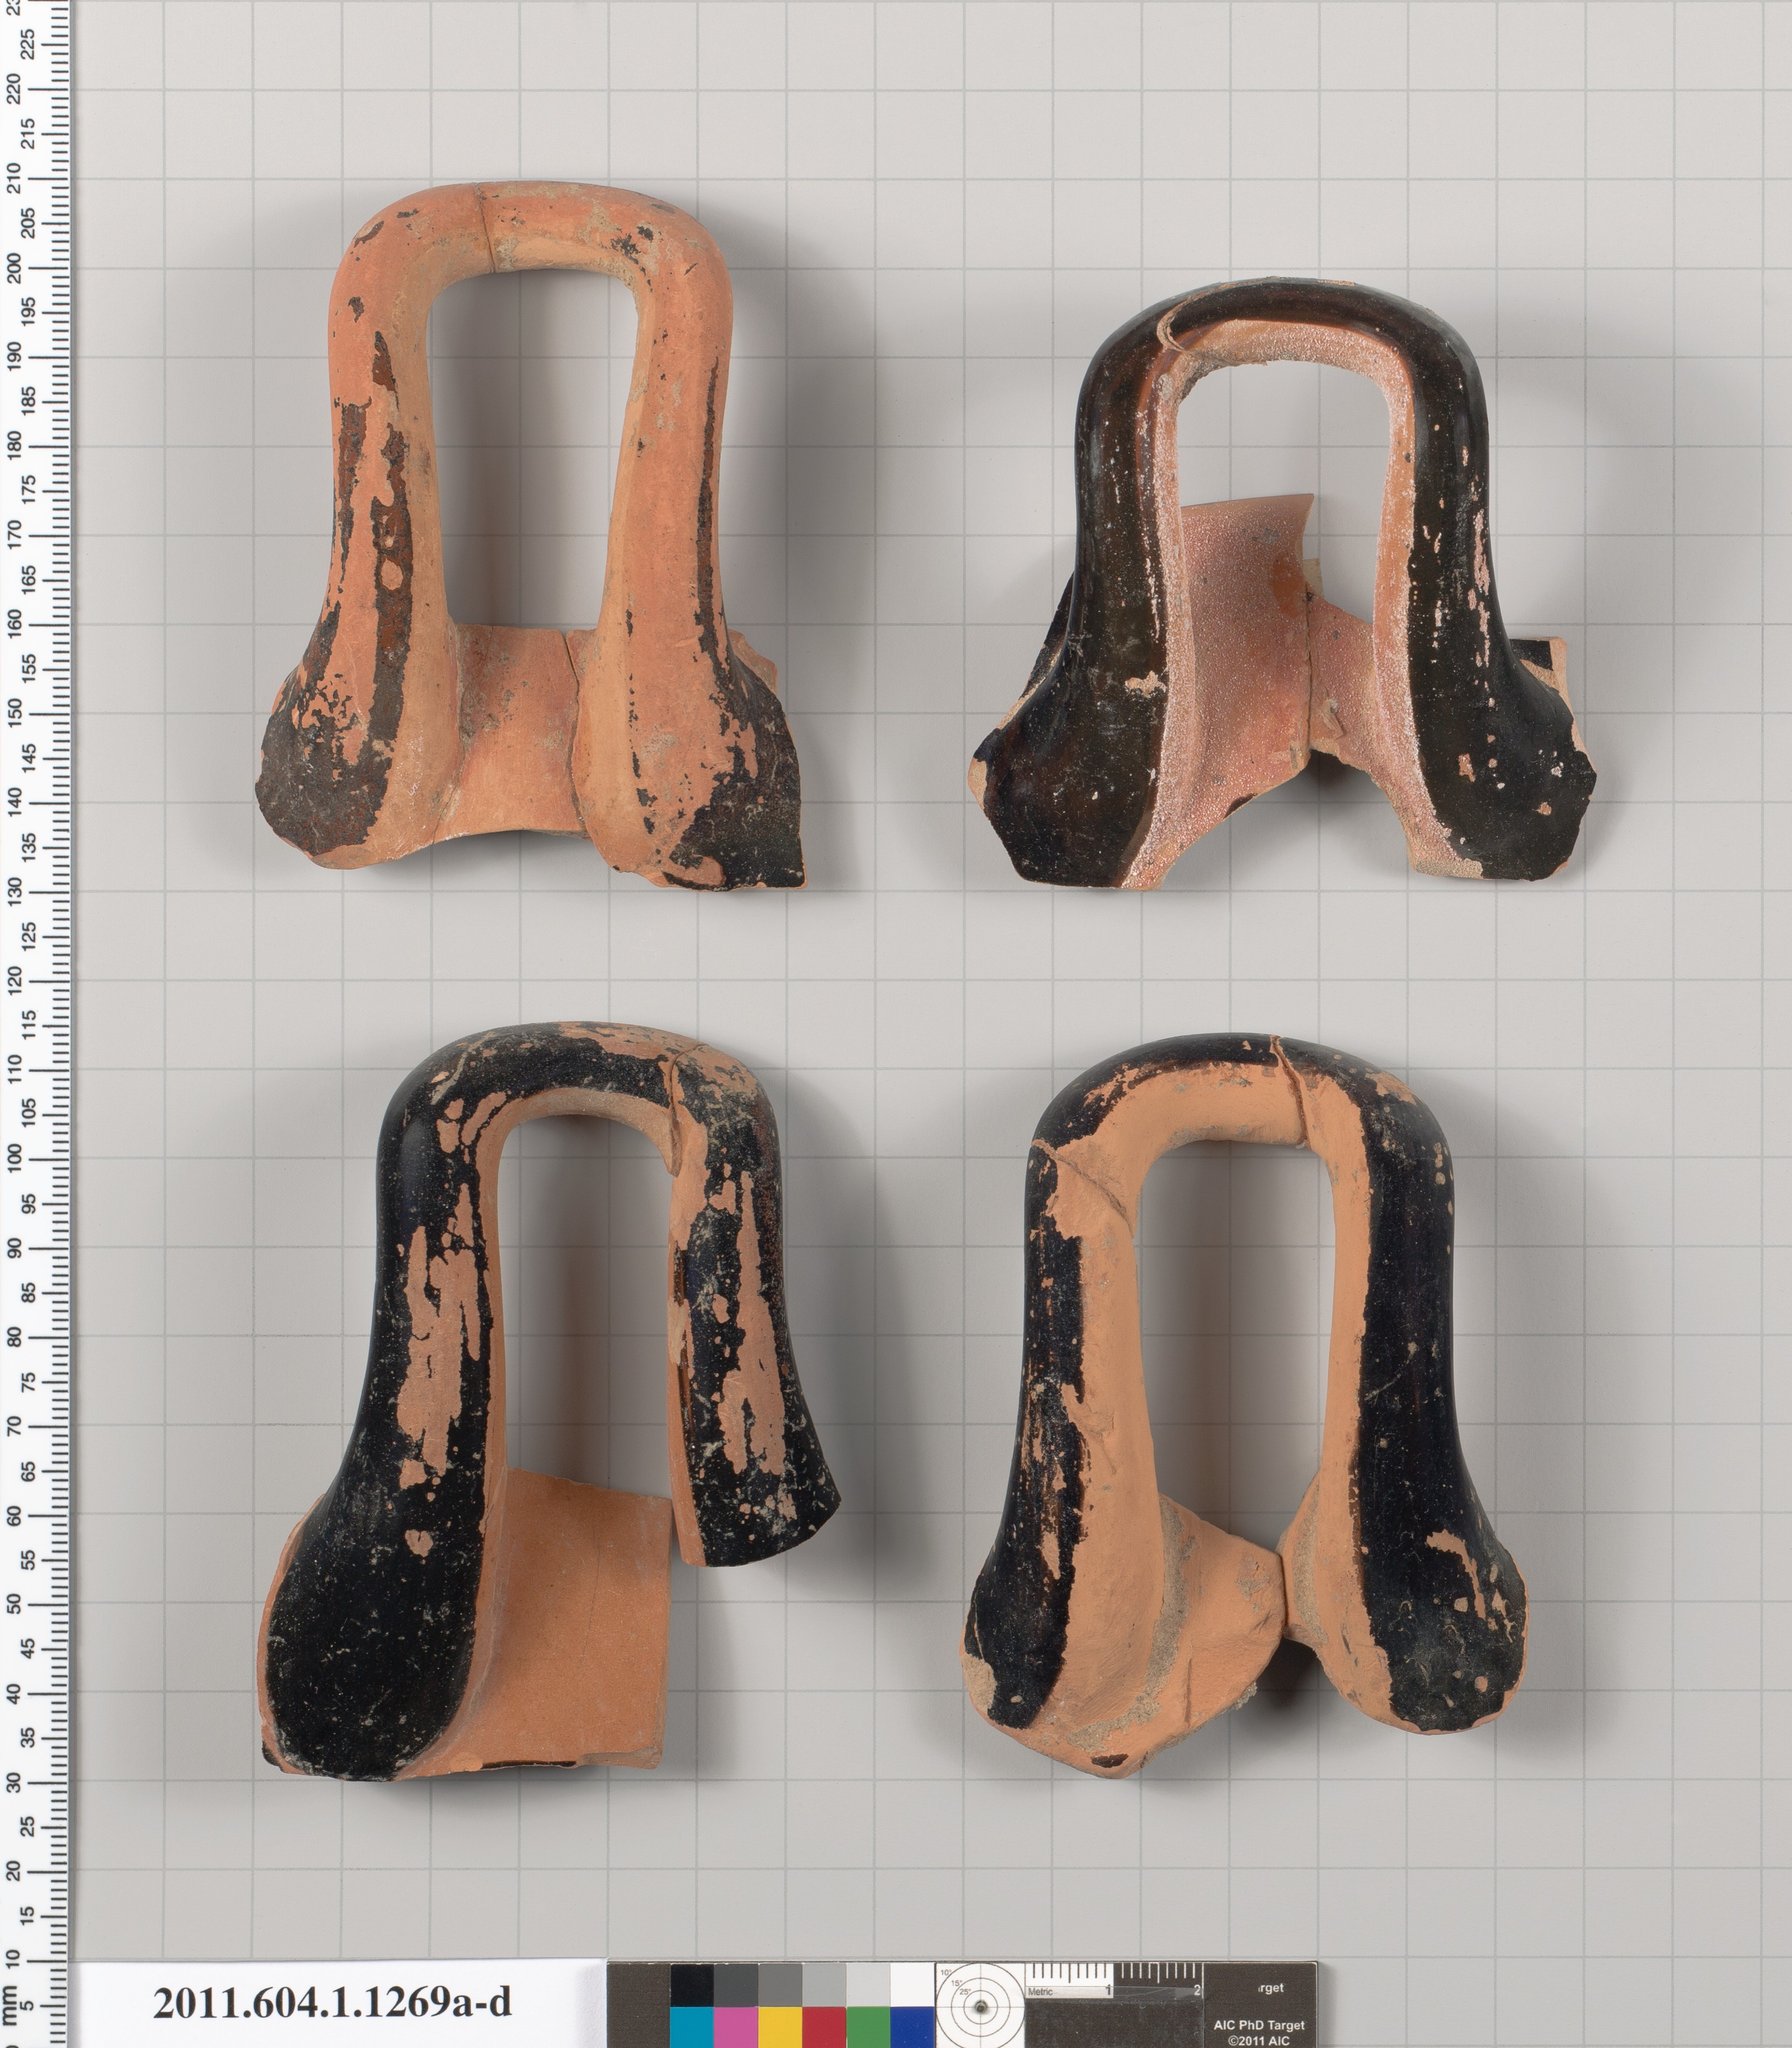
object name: kylix fragment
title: Terracotta fragments of kylikes (drinking cups)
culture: greek, attic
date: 500-401 BCE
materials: terracotta